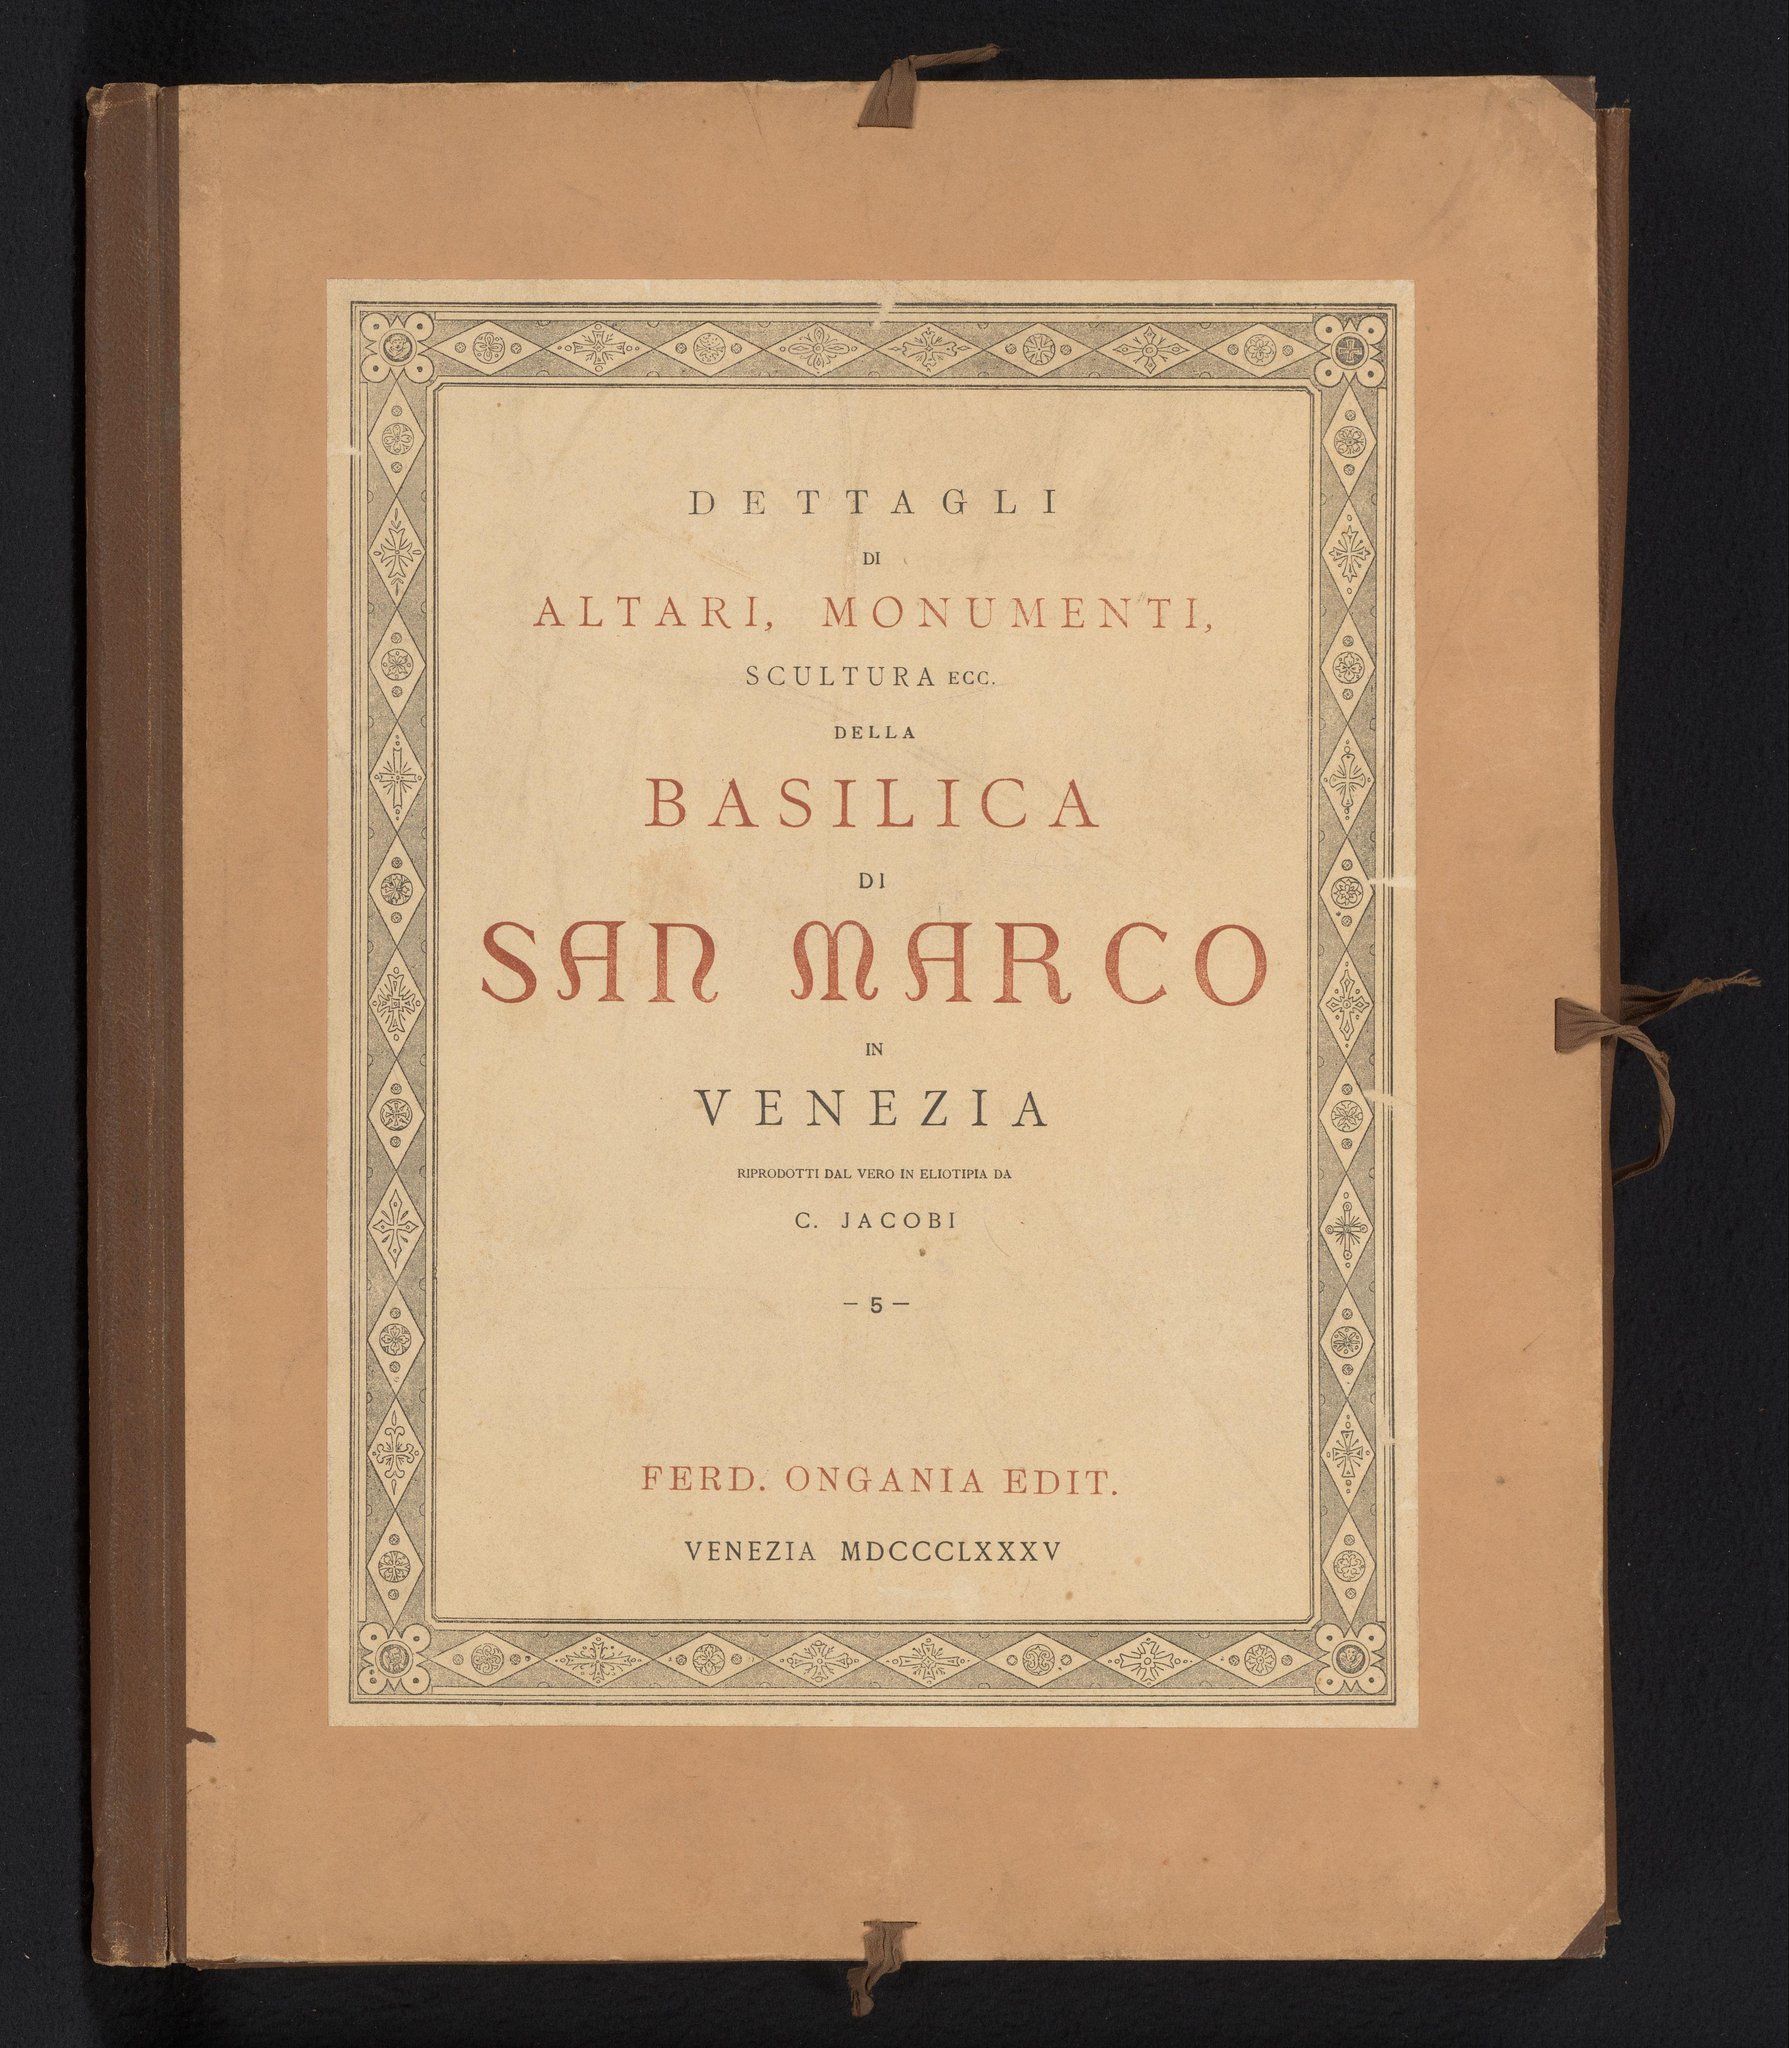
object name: wrapper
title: Dettagli di altari, monumenti, scultura ecc. della Basilica di San Marco in Venezia / riprodotti dal vero in eliotipia da C. Jacobi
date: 1885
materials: cardboard, linen, paper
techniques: photograph, printing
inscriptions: date: ‘SEPT/ 1998’, inscription: ‘Portafolgio N.o V./ Coperta 5./ Contiene Tav. 191 a. 240.’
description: Omslag met 79 prenten op 53 bladen en 2 tekstbladen.